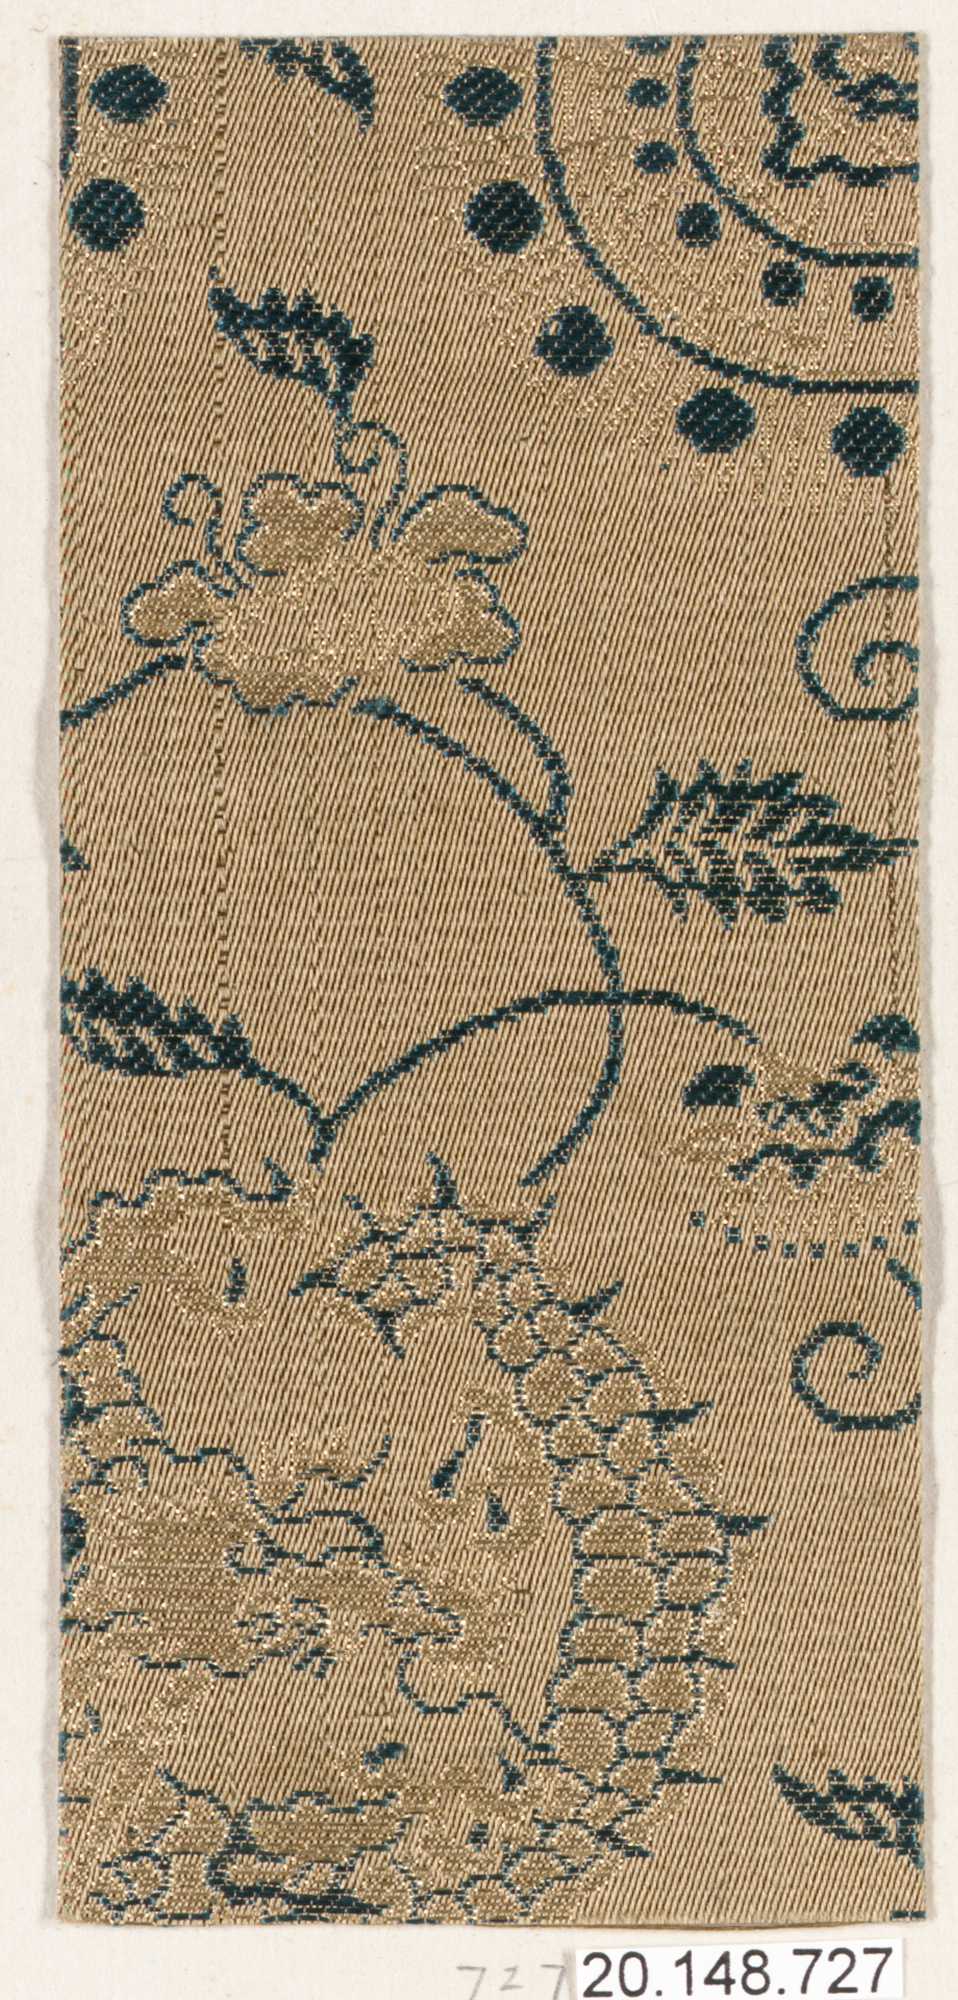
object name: piece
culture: japanese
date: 1601-1700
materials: silk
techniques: compound weave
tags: flowers,leaves